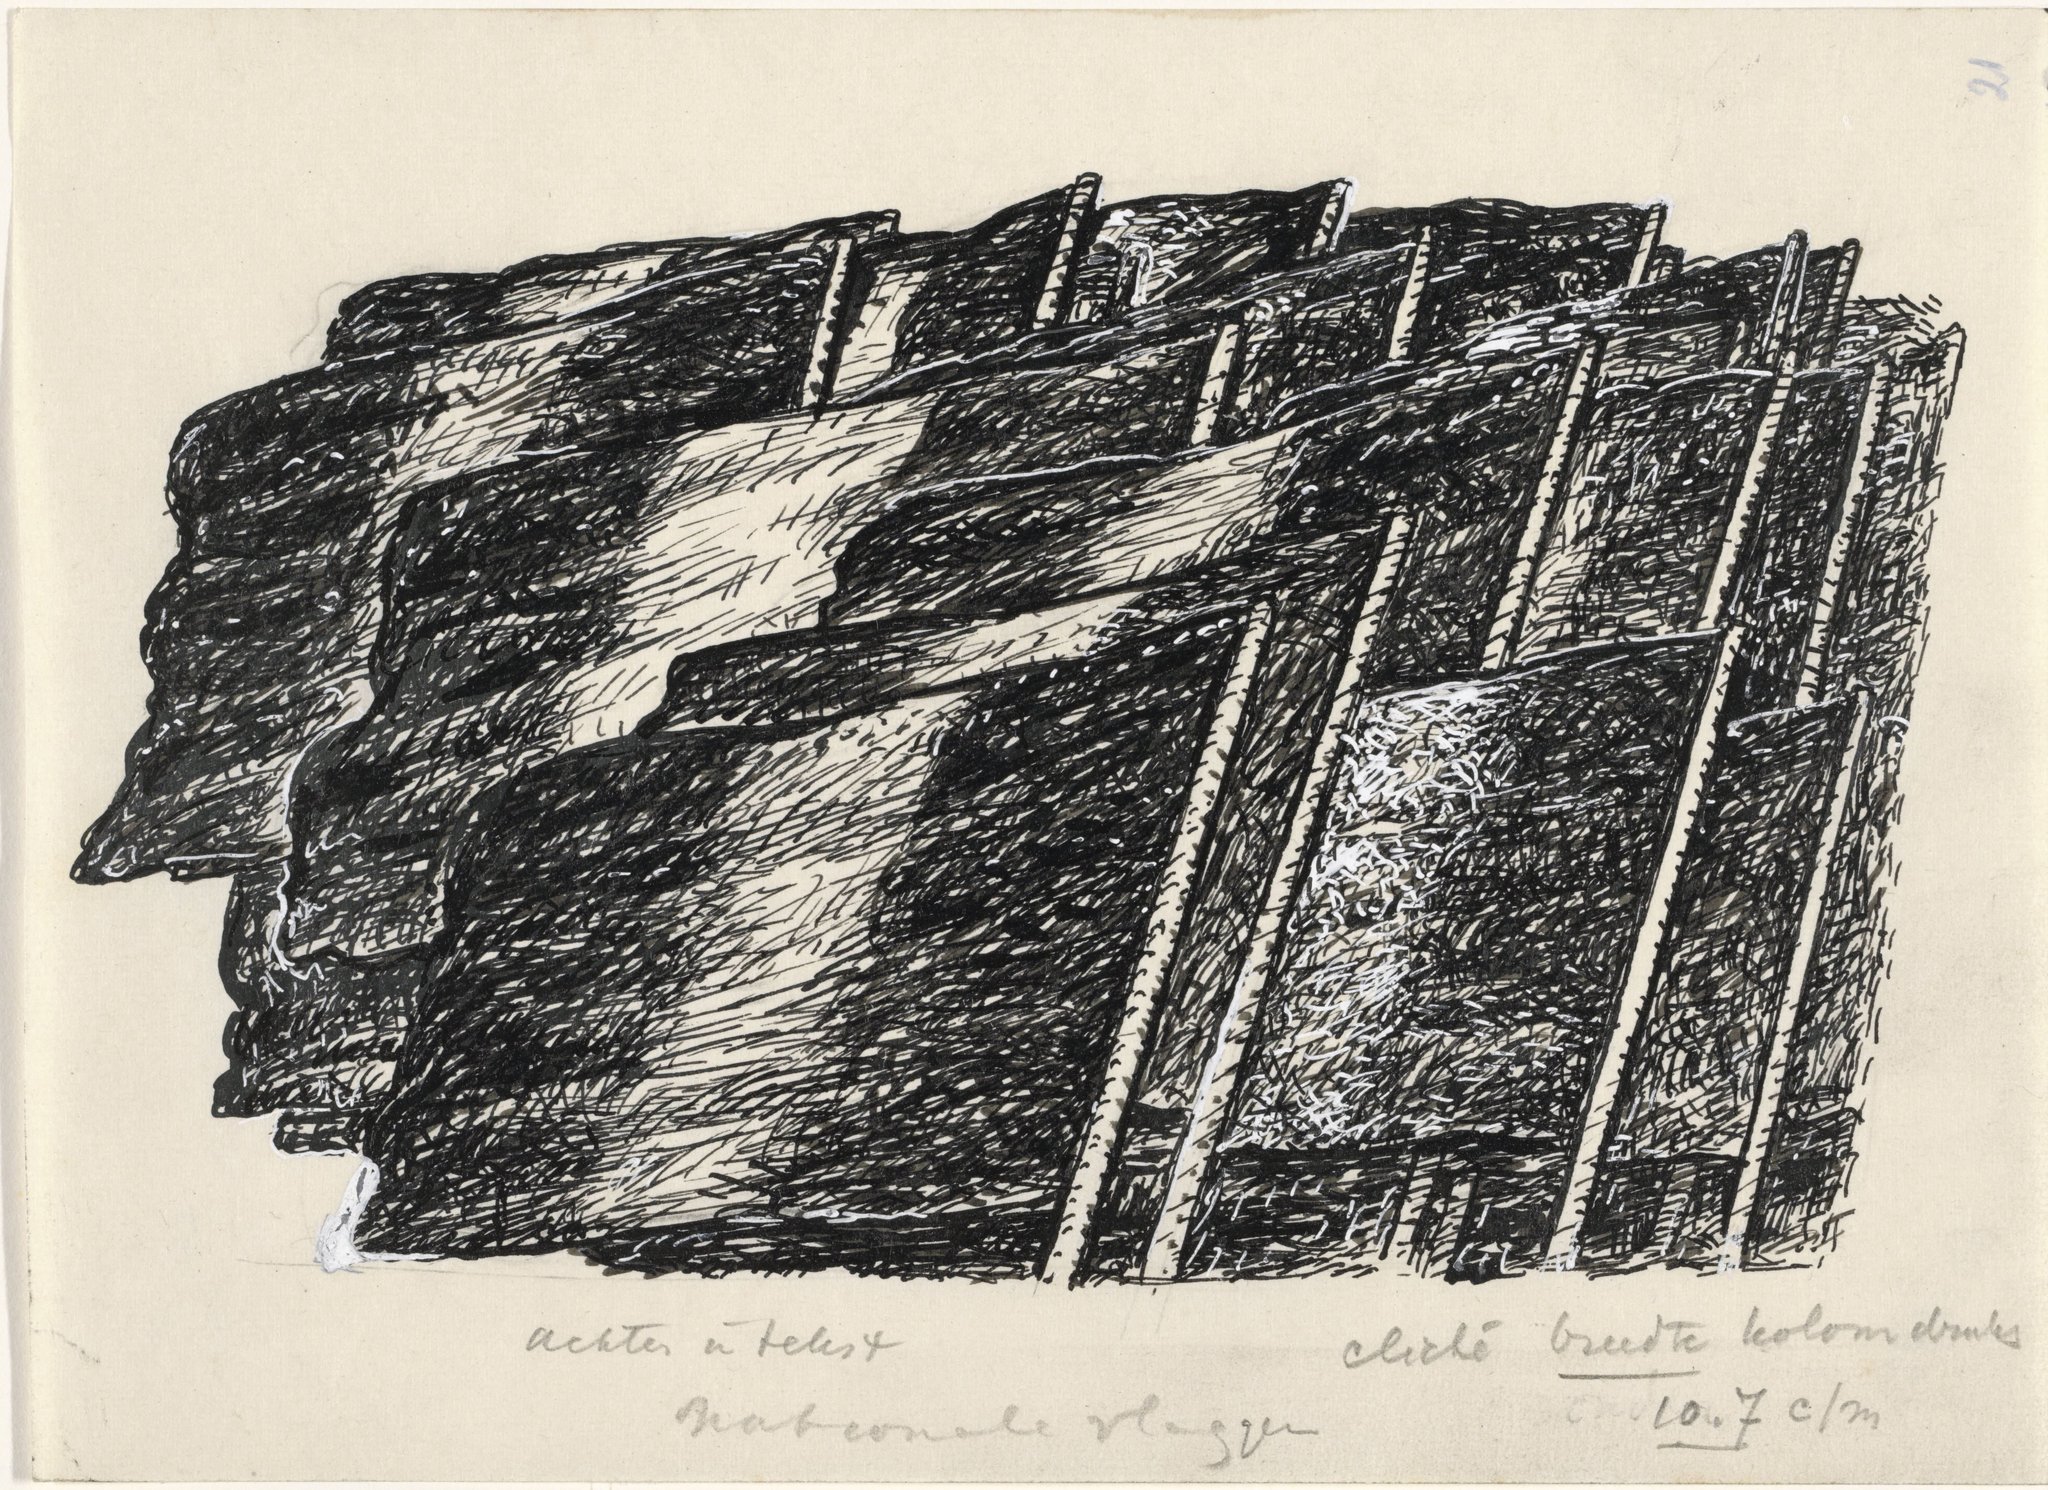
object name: boekillustratie ontwerp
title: Nationale vlaggen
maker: leo gestel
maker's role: draughtsman, print maker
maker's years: 1881-1941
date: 1934-1936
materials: paint, ink, paper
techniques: pen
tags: (cohen, van anarchist tot monarchist) specific works of literature (with author, title), flag, colours (as symbol of the state, etc.) (+ nation; national)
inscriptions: clichéaanwijzing, recto, handgeschreven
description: Ontwerp voor een boekillustratie voor: Cohen, Alexander. Van anarchist tot monarchist. Amsterdam: De Steenuil, 1936.